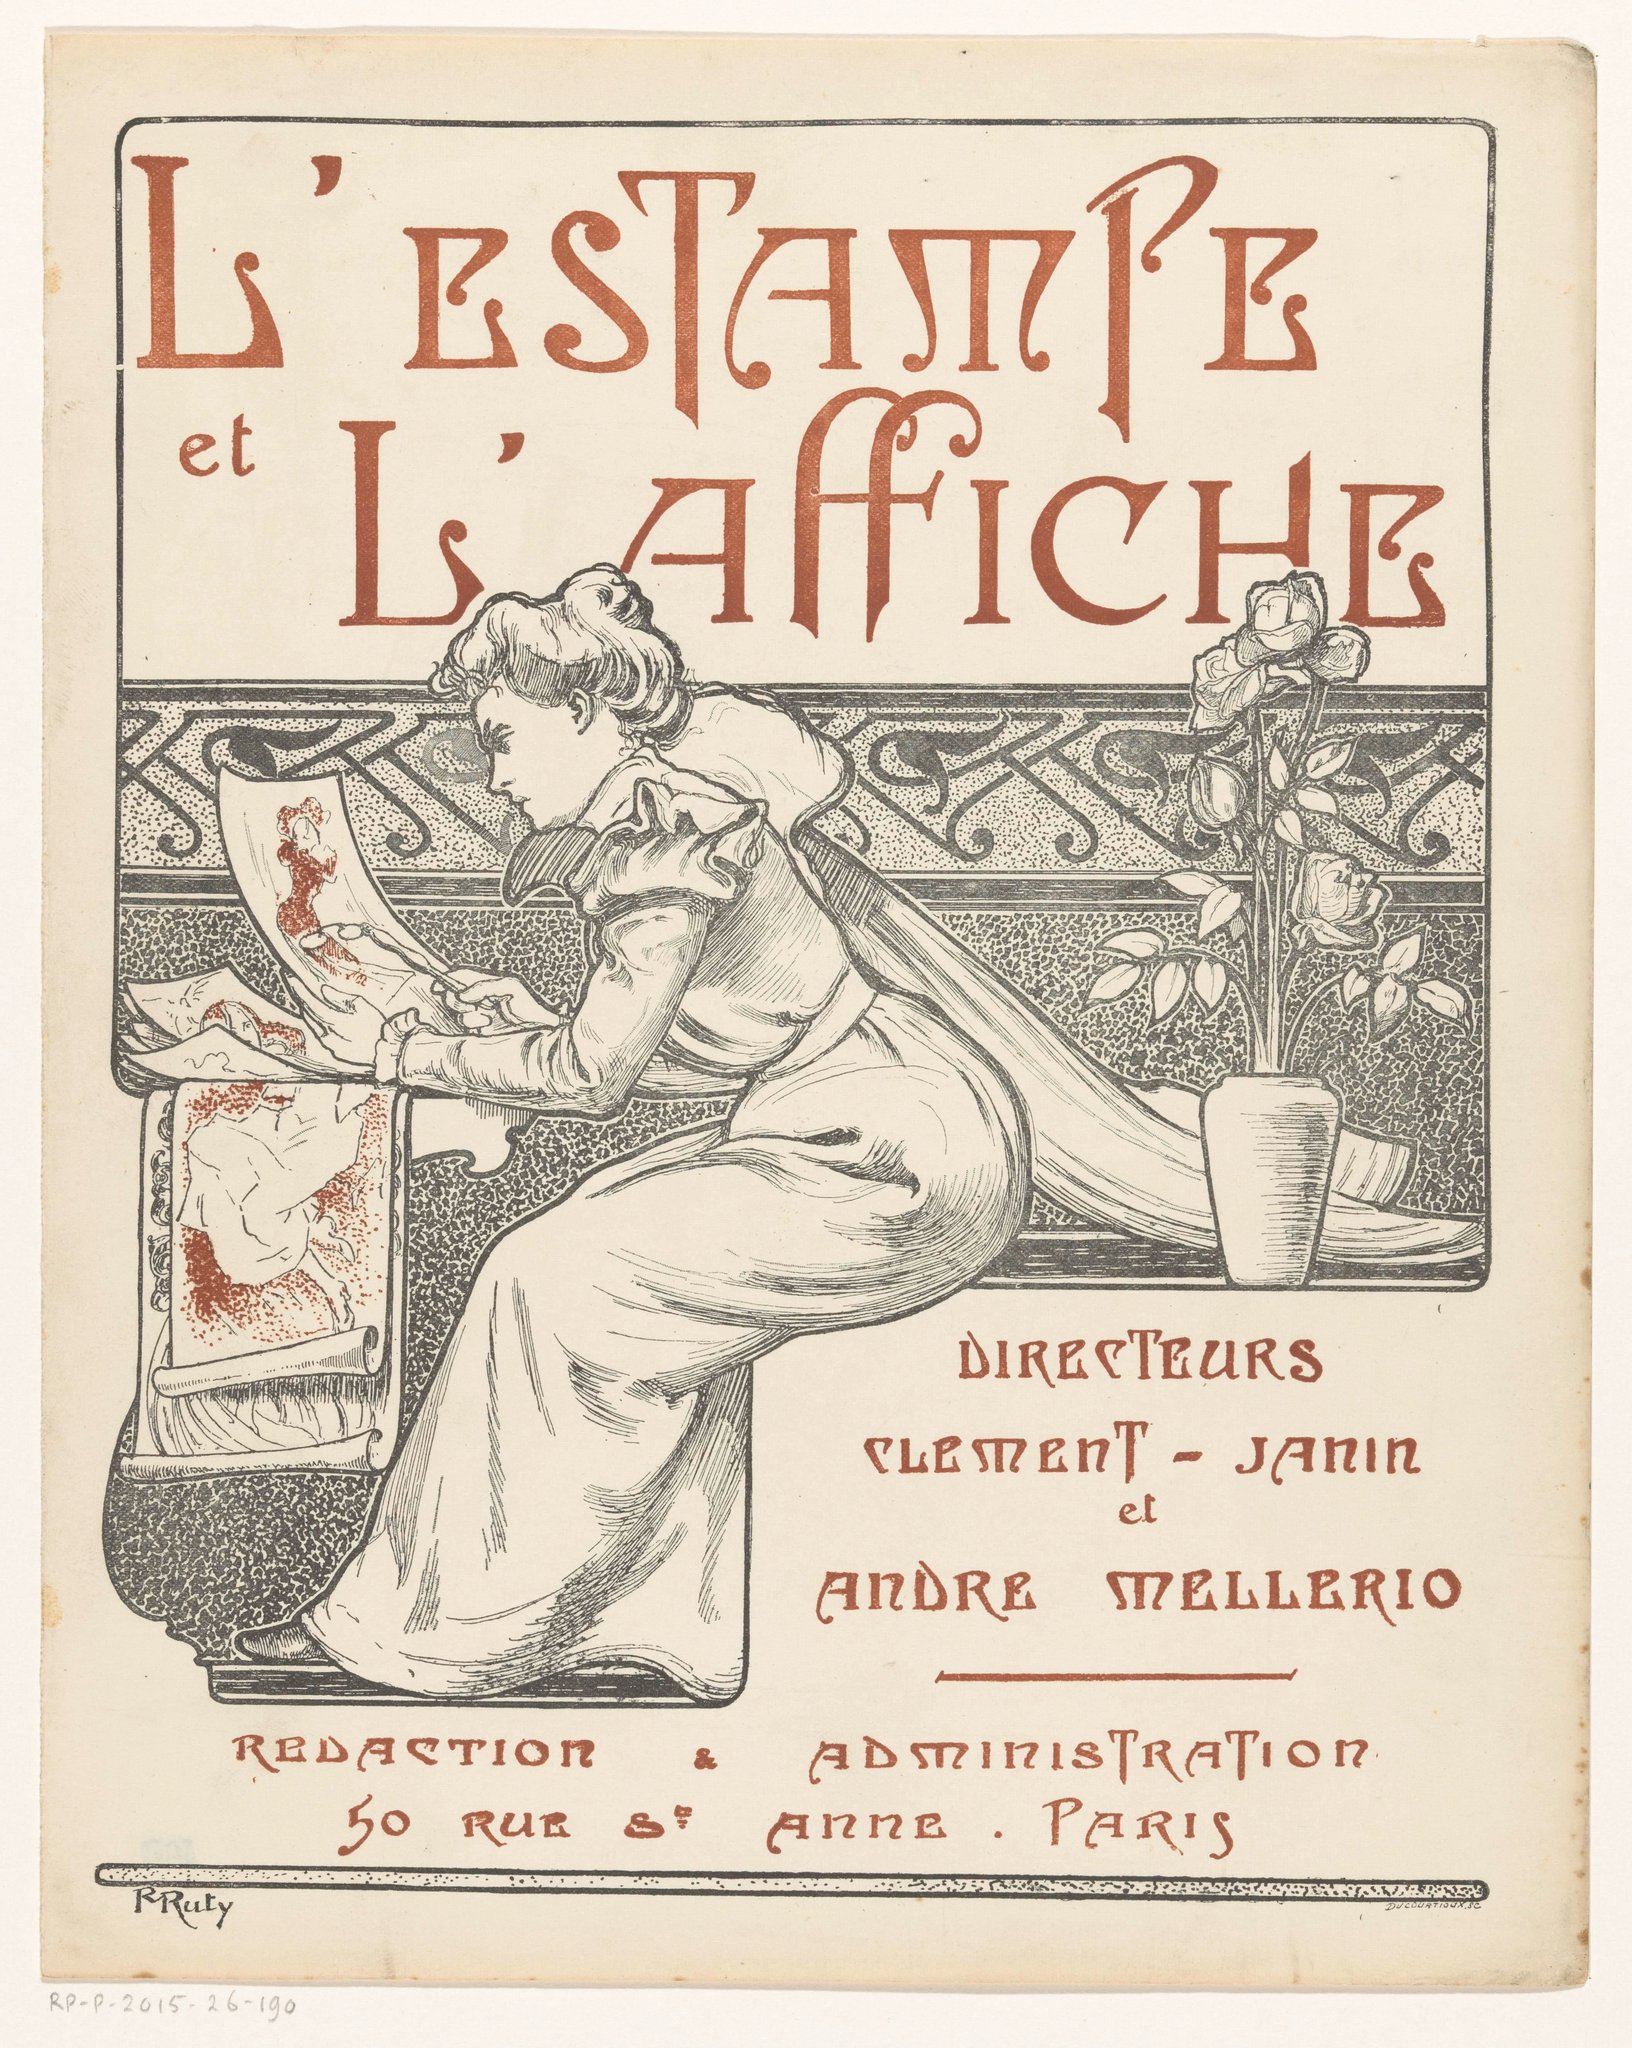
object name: print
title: Omslag voor het tijdschrift L'Estampe et l'Affiche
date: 1897-1899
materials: paper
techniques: lithograph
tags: sitting on an elevation - aa - female human figure (+ sideview, profile), print, e.g.: engraving, etching, lithograph, art collecting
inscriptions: collector's mark: Lugt 2228, collector's mark: Lugt 4780, collector's mark: Lugt 4779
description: Een zittende vrouw bekijkt prenten, in haar hand een lorgnet.